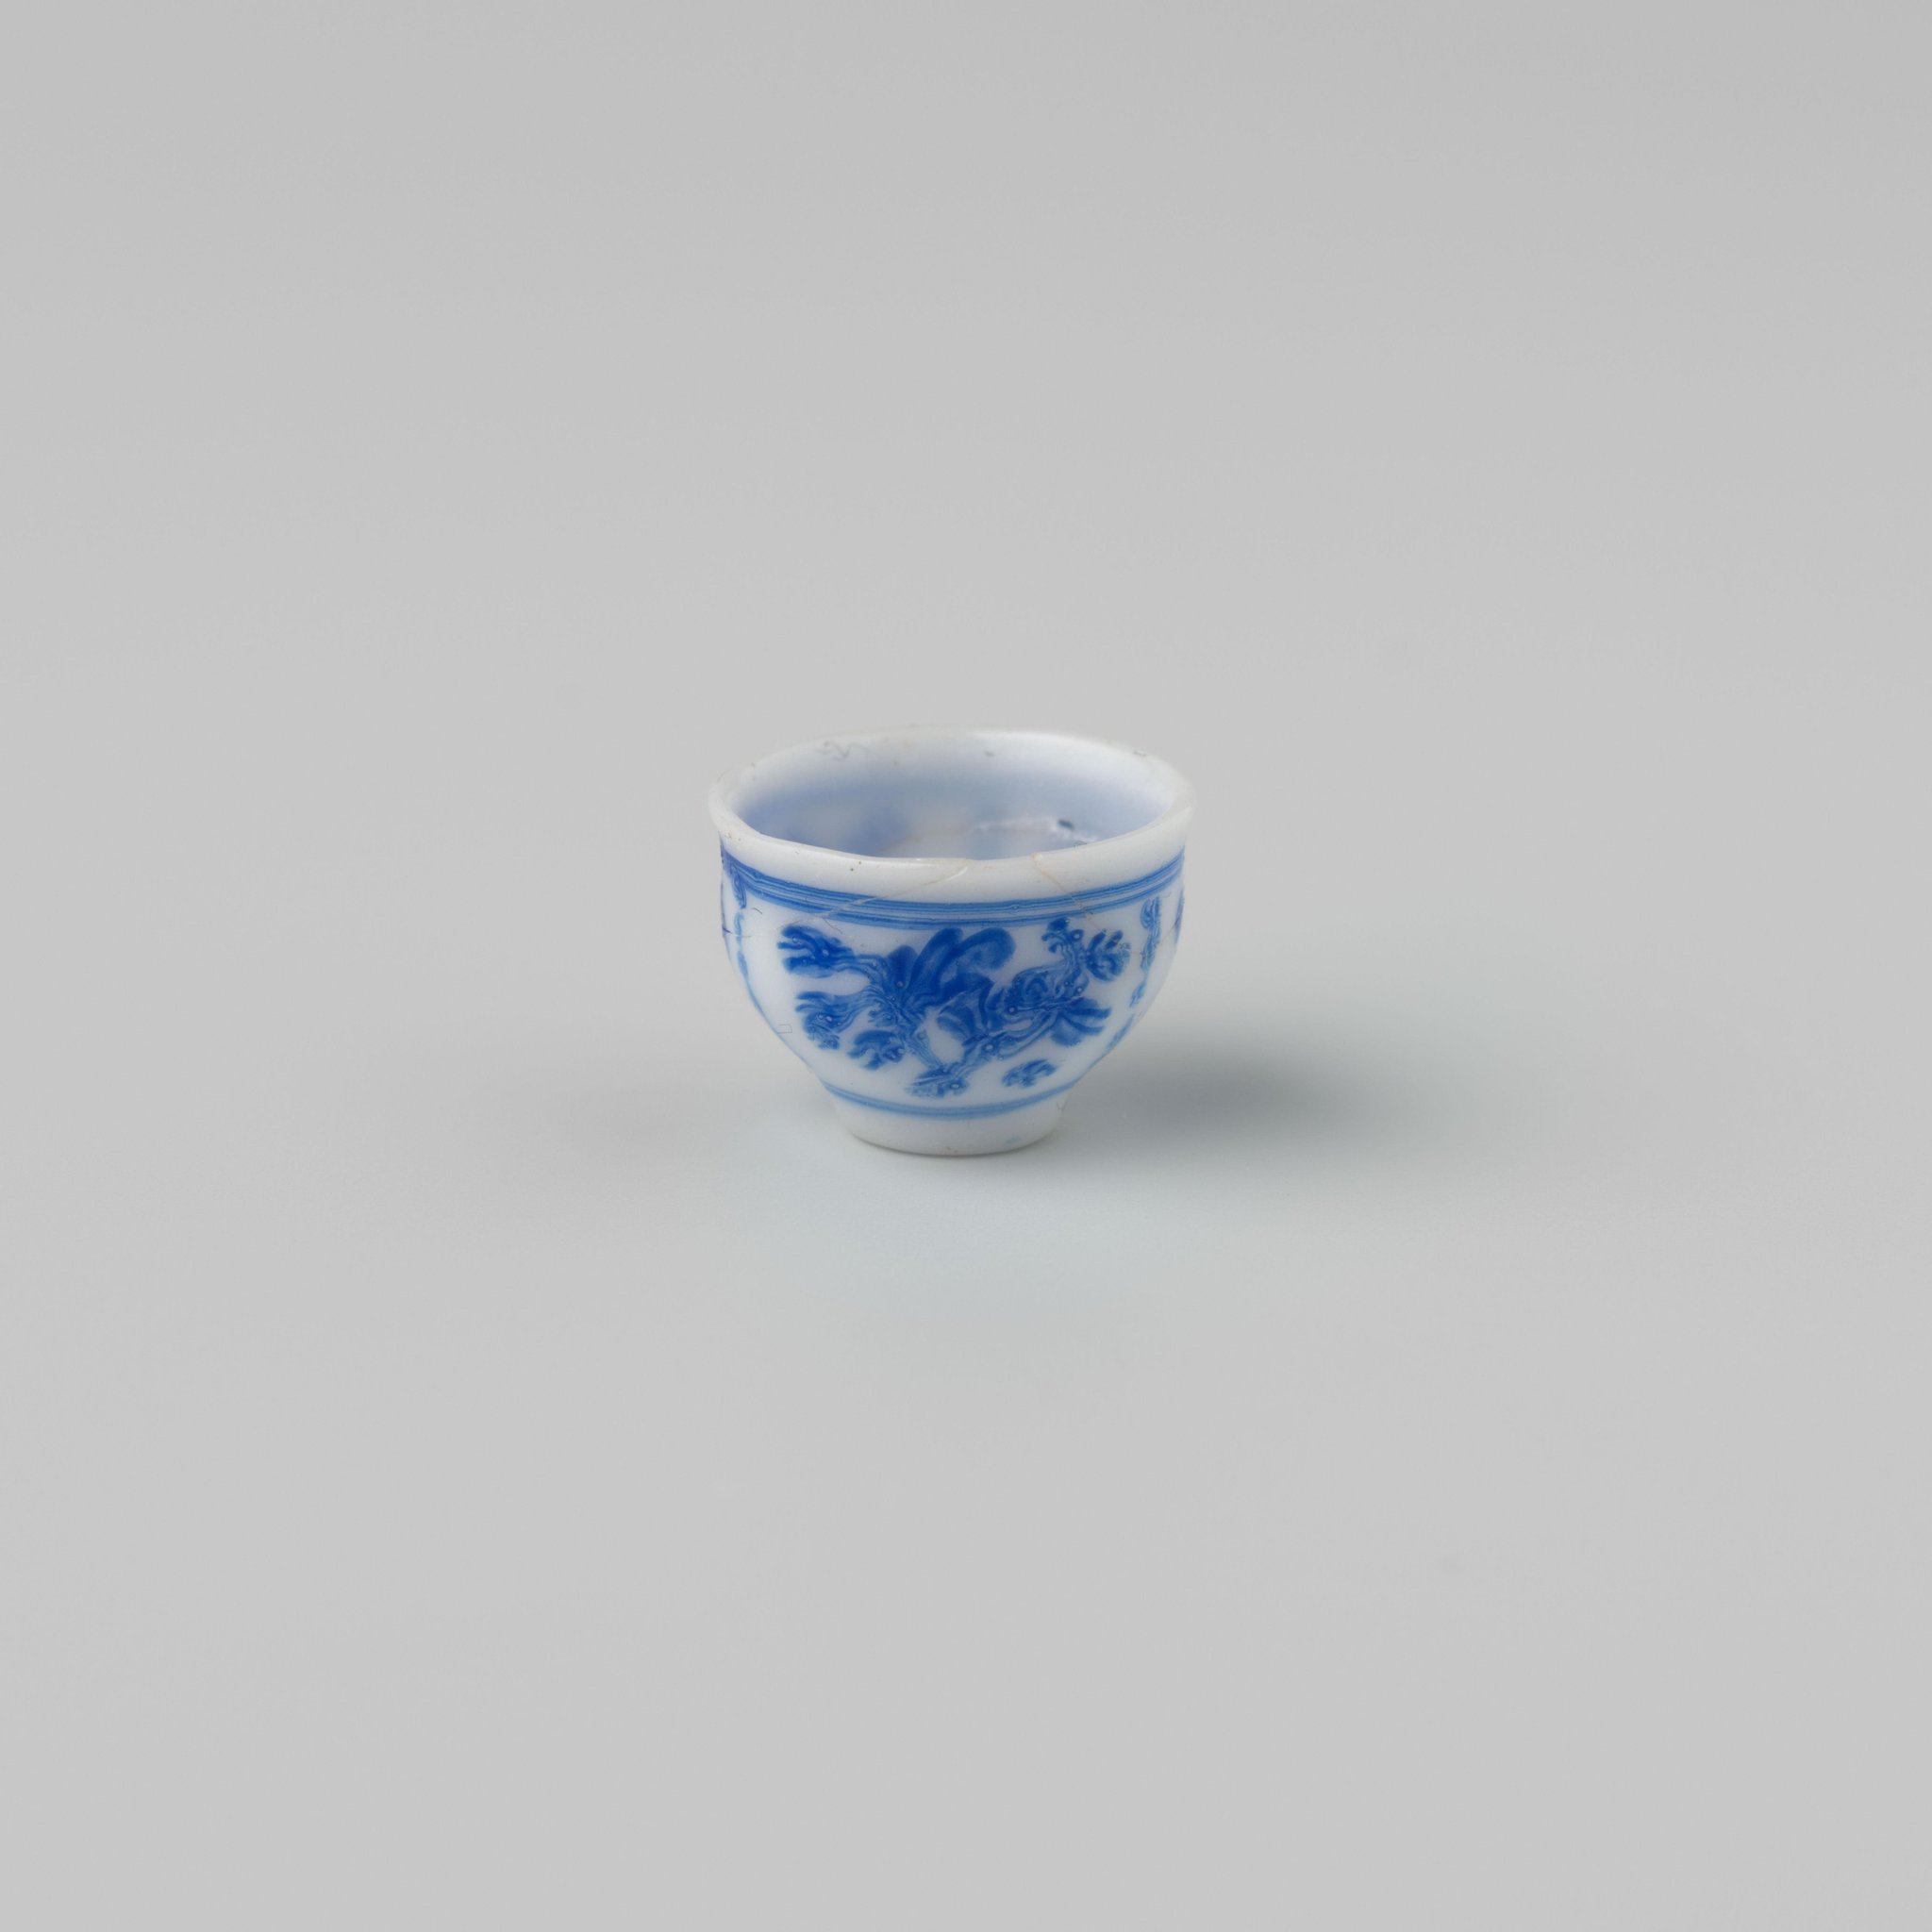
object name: miniature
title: Theekopje van melkglas met blauwe emailverf beschildering, imitatie Chinees porselein met 'bloem' decoratie in vakken; op standring en met gladde mondrand.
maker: Anonymous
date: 1675-1710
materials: glass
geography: amsterdam